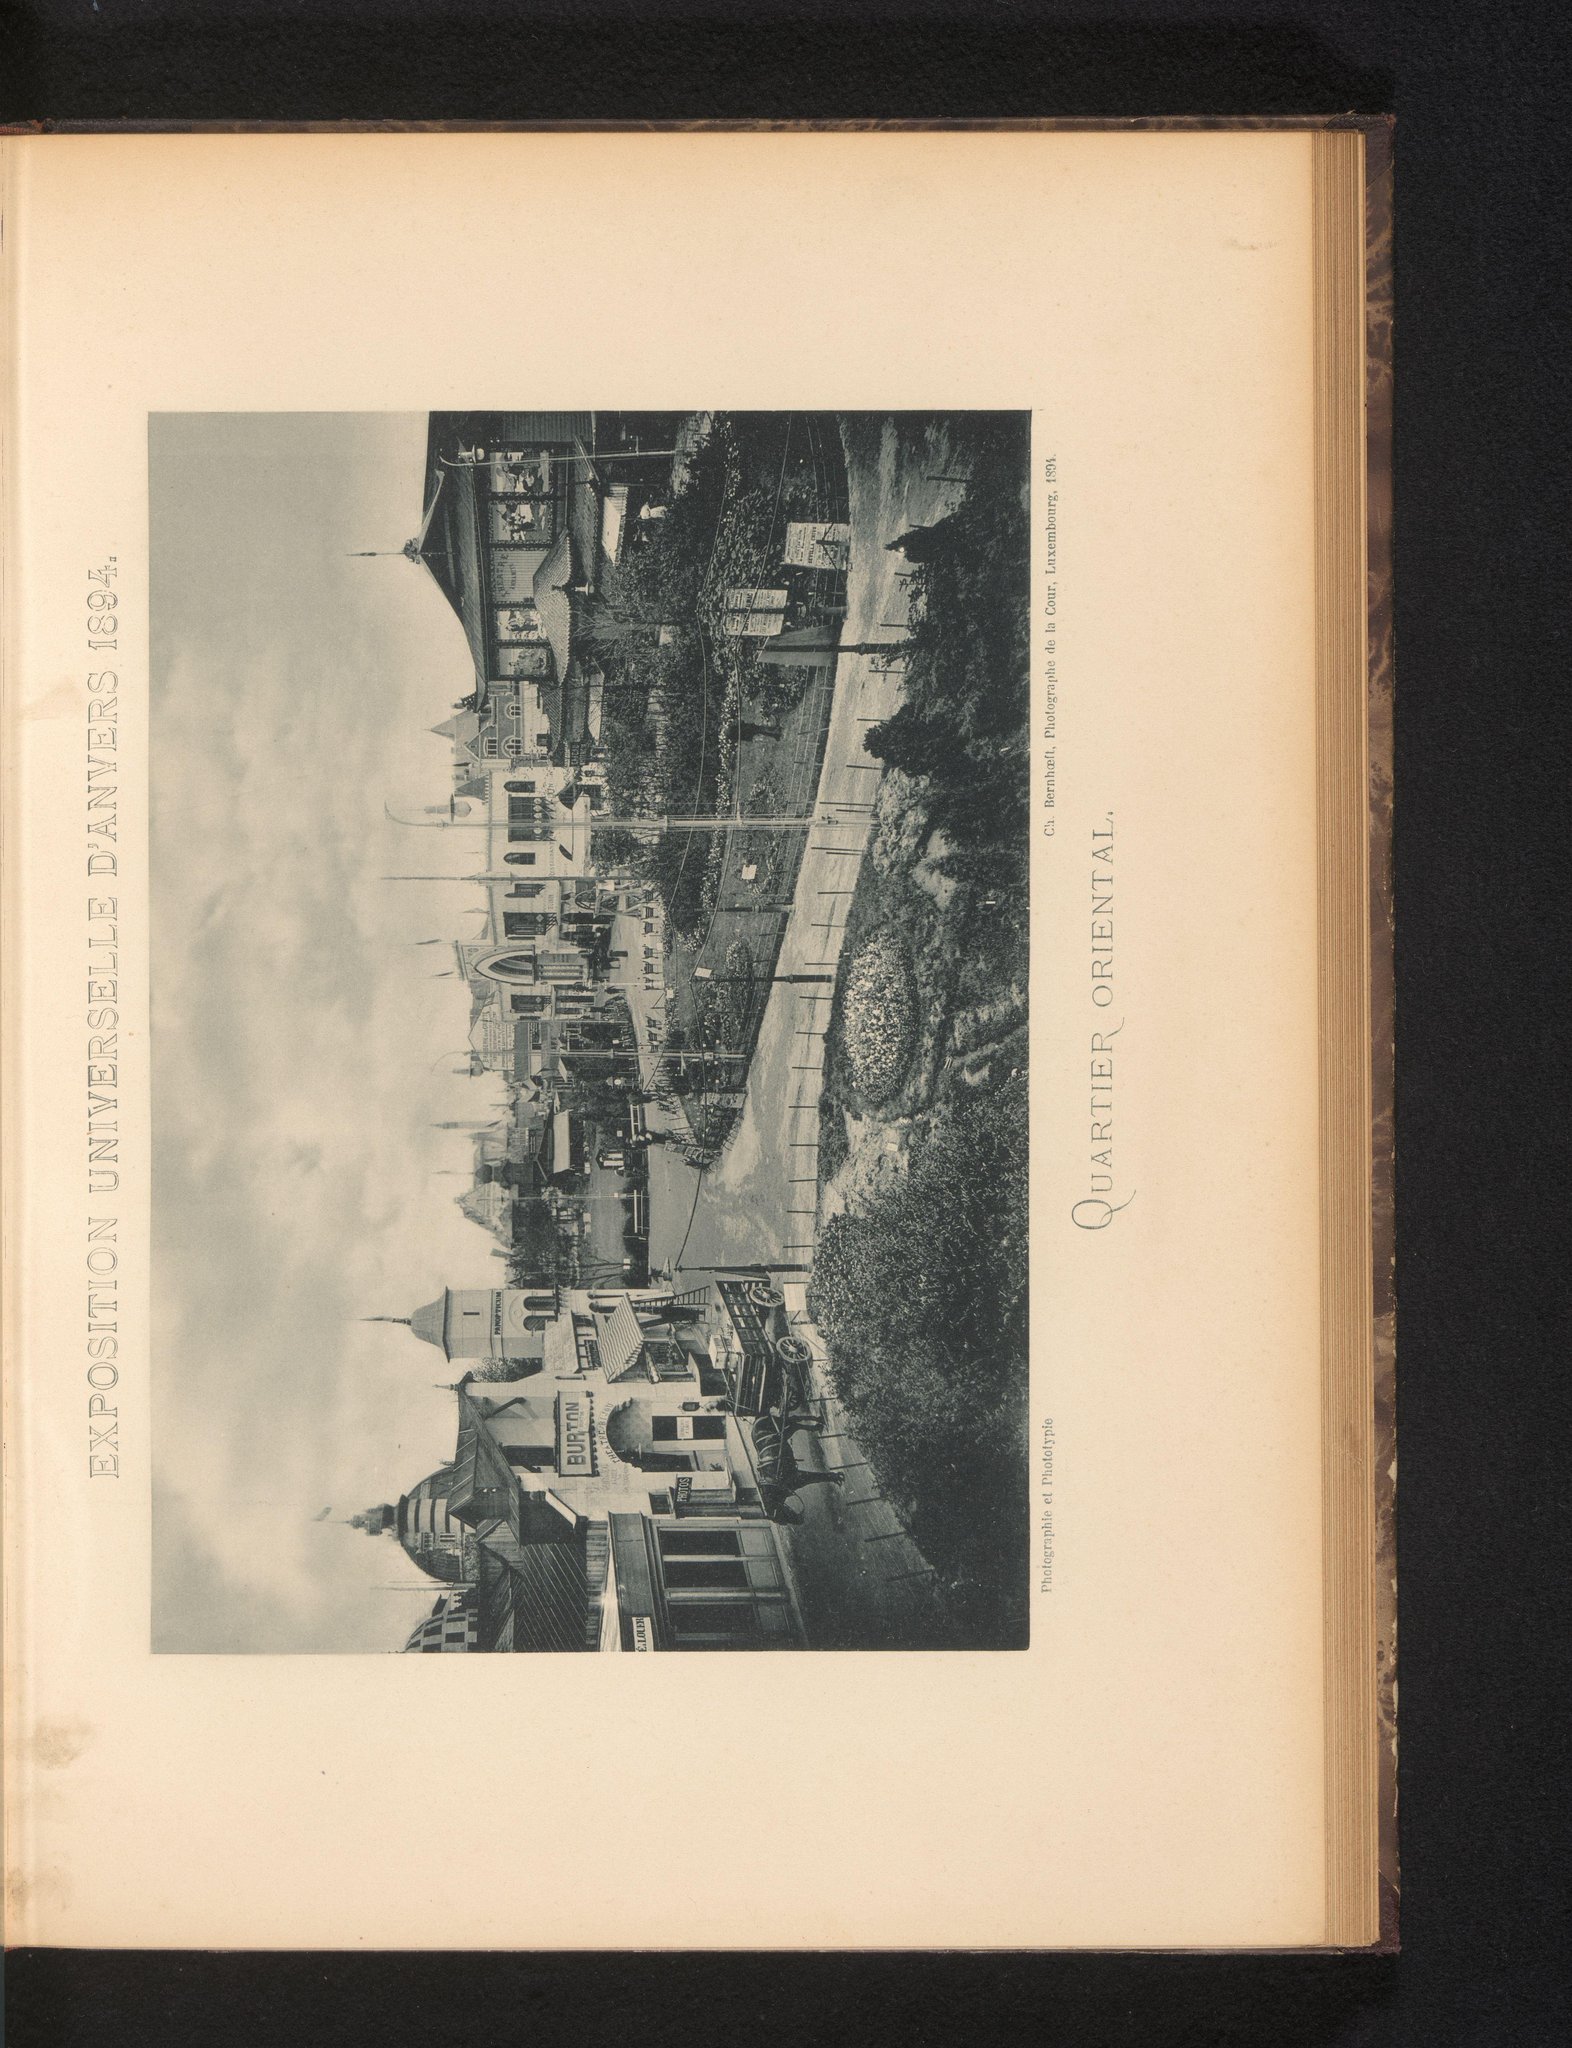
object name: photomechanical print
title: Exposition Universelle d'Anvers 1894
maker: charles bernhoeft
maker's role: publisher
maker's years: 1859-1933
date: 1894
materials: paper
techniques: photograph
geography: luxembourg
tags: prospect of village, silhouette of village, world fair, world exhibition, antwerp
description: Prent op derde ongenummerde pagina na pagina 78.